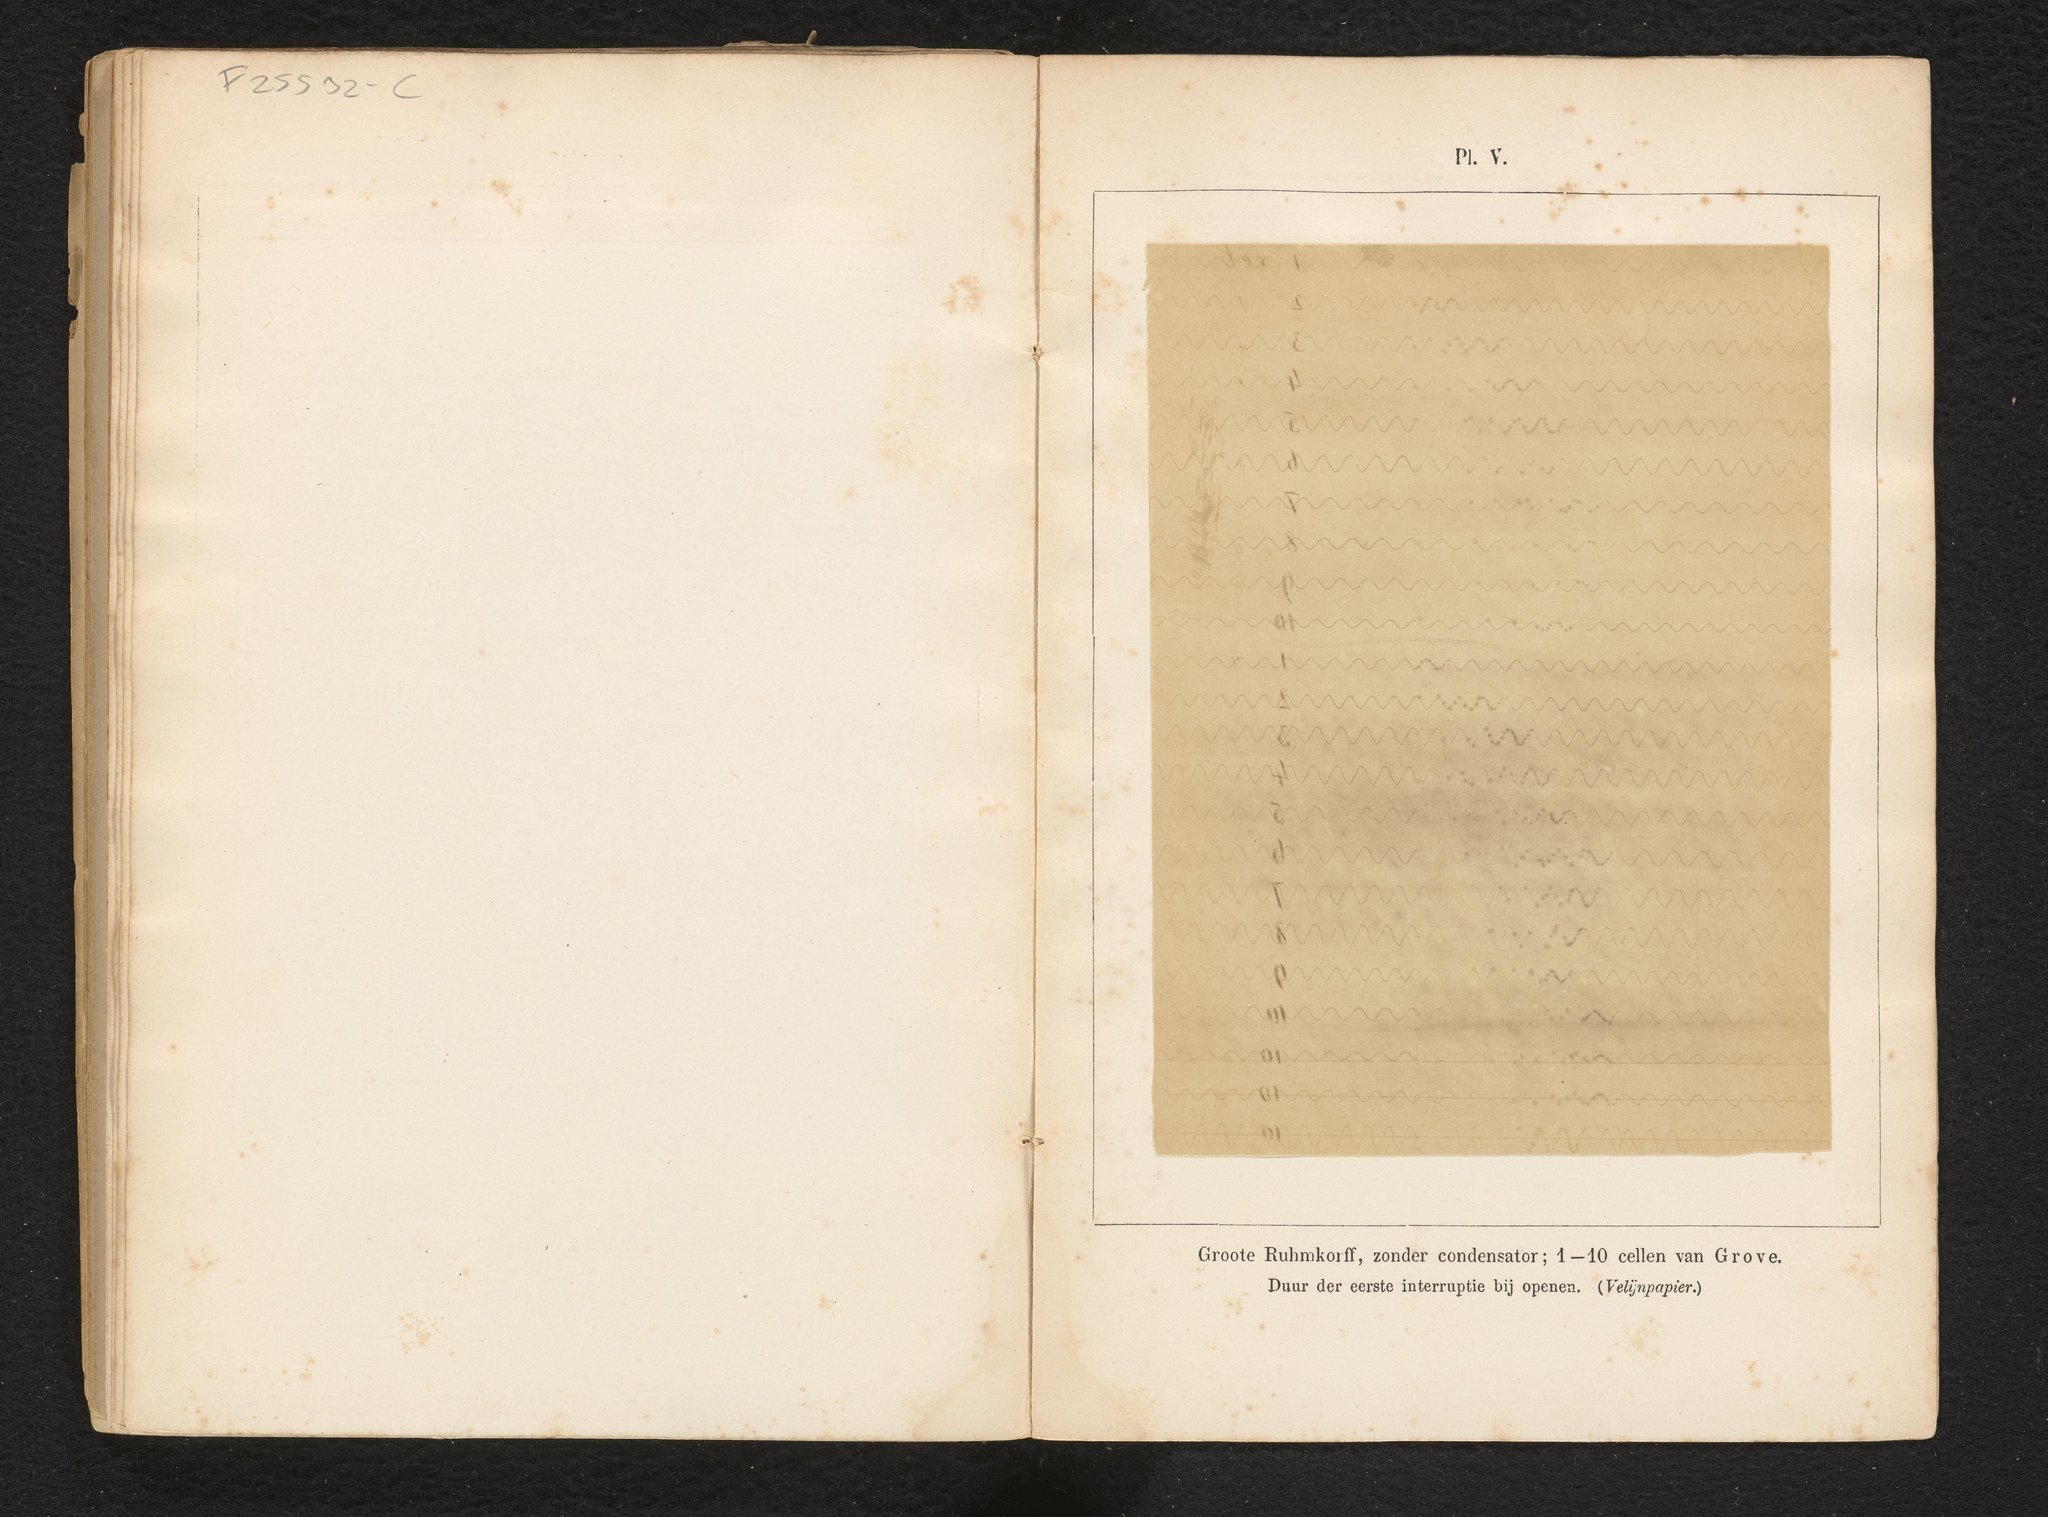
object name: page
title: Registratie van electriciteitsgolven opgewekt door een vonkinductor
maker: willem cornelis van dijk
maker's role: painter, print maker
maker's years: 1826-1881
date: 1865-1870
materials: paper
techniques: albumen print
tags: electrical phenomena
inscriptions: number: ‘Pl. V.’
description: Foto op elfde ongenummerde pagina na pagina 95.